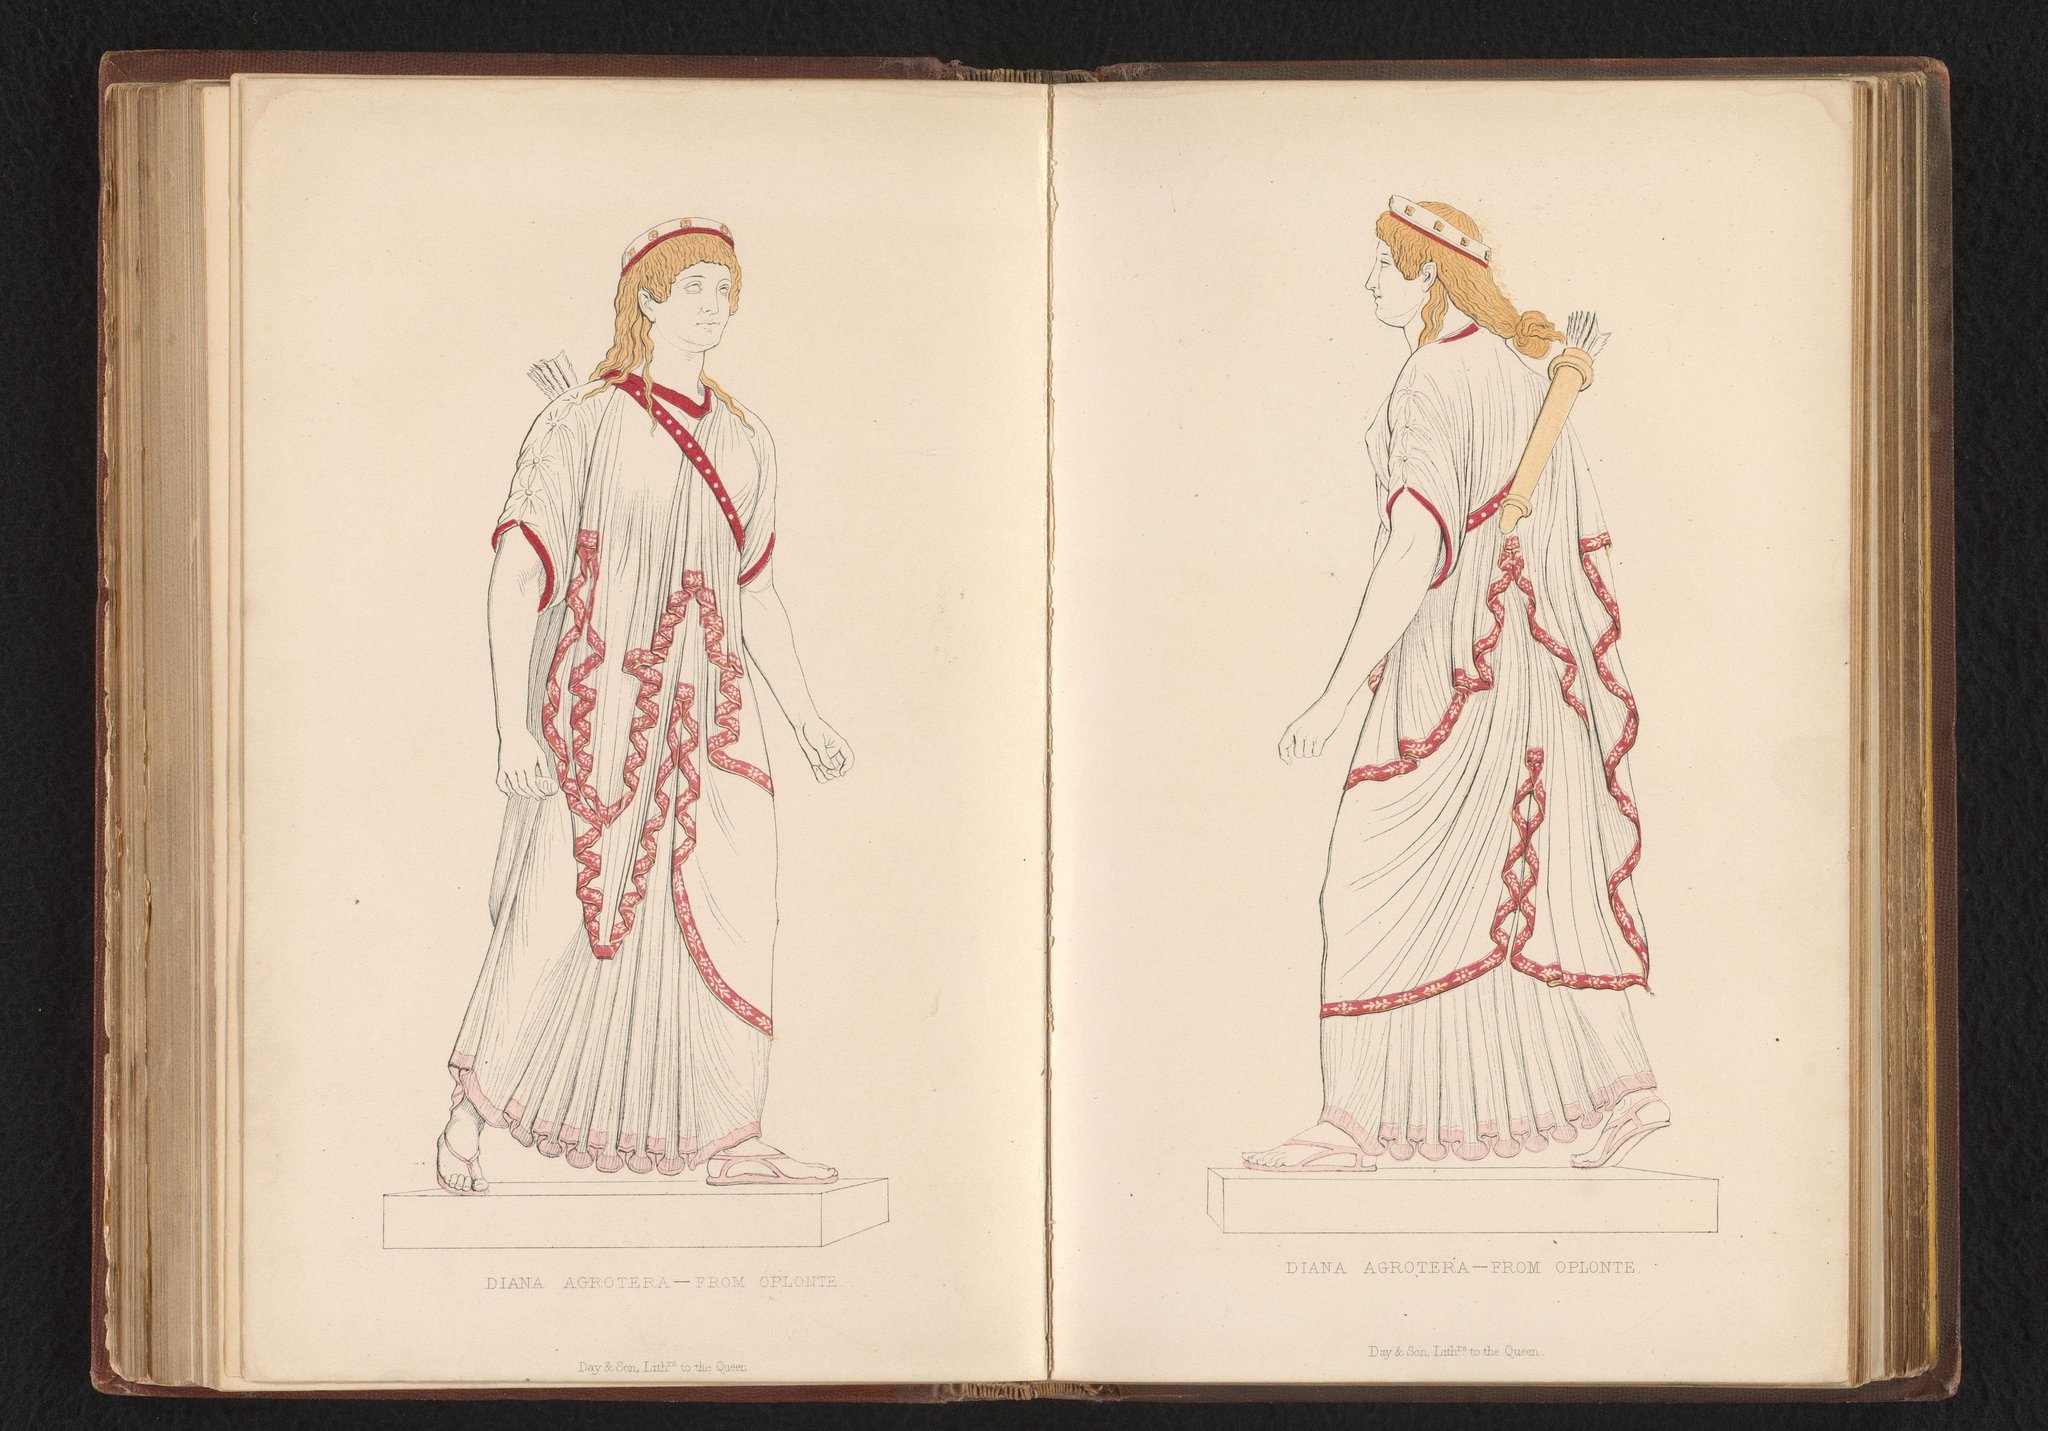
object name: page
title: Diana Agrotera, from Oplonte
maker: Anonymous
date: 1855-1860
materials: paper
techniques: lithograph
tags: (story of) diana (artemis)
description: Prent op derde ongenummerde pagina na pagina 142.